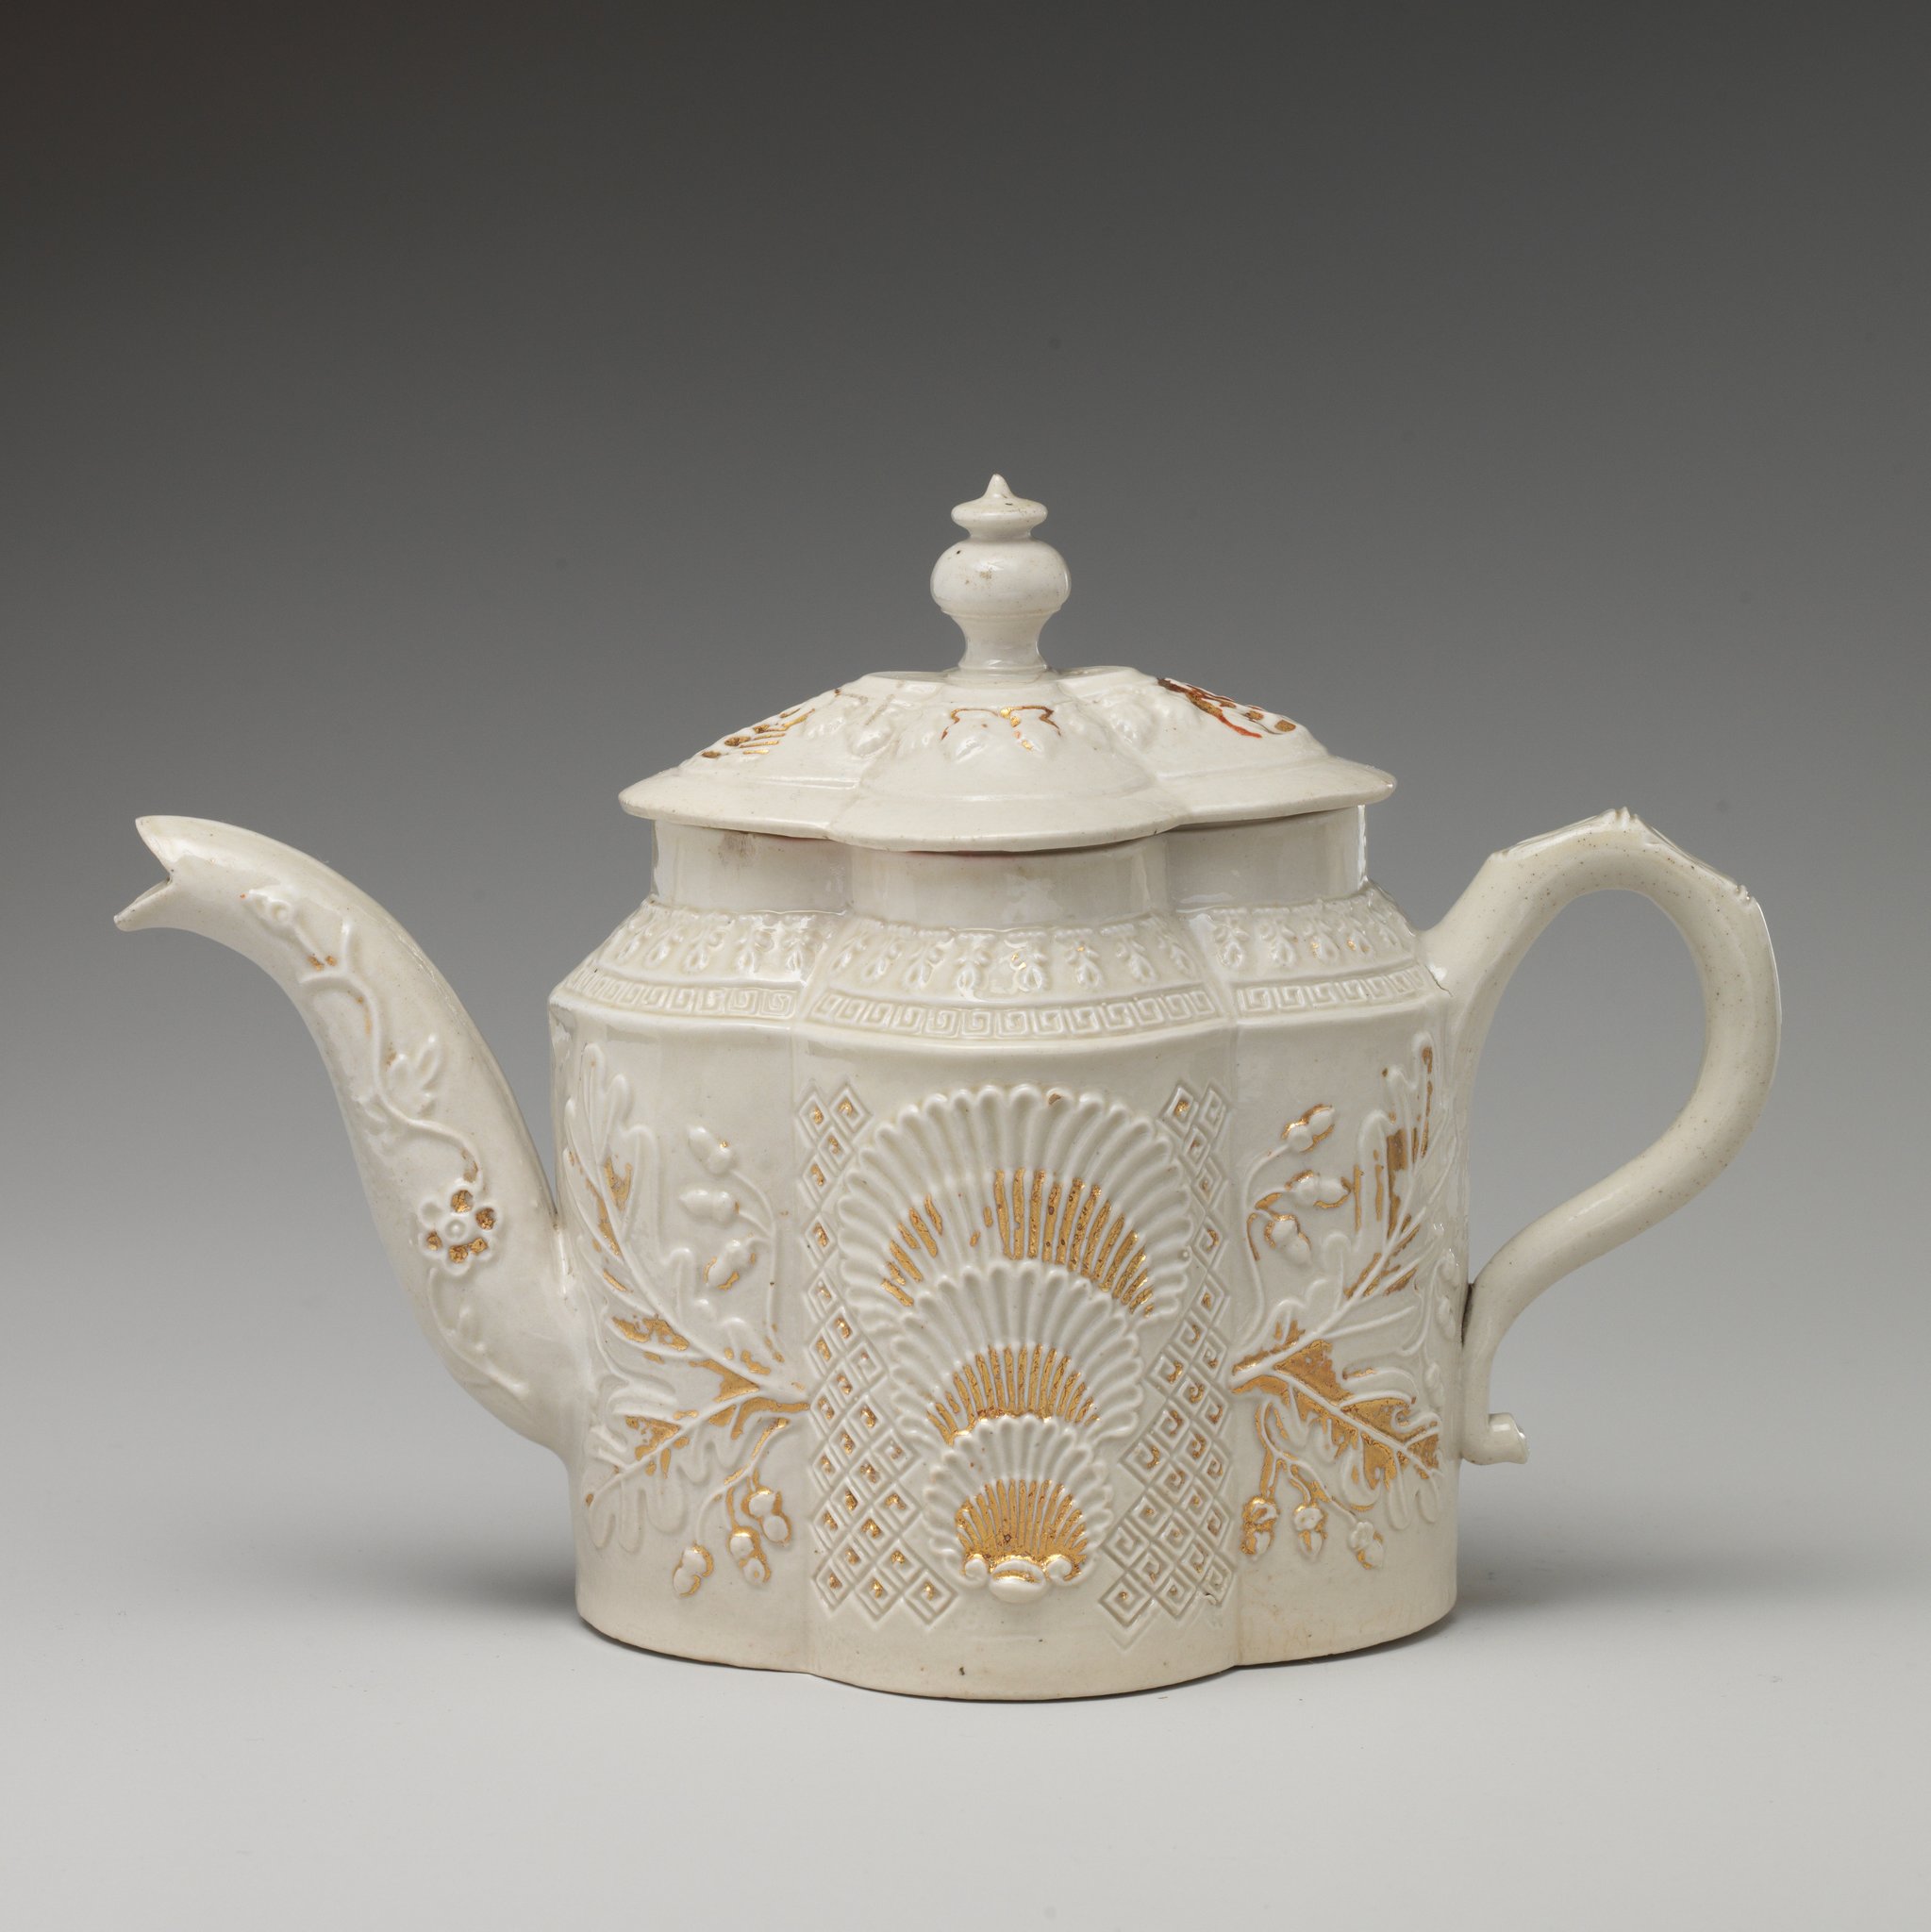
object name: teapot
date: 1750-1760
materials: stoneware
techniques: gilding, salt glaze